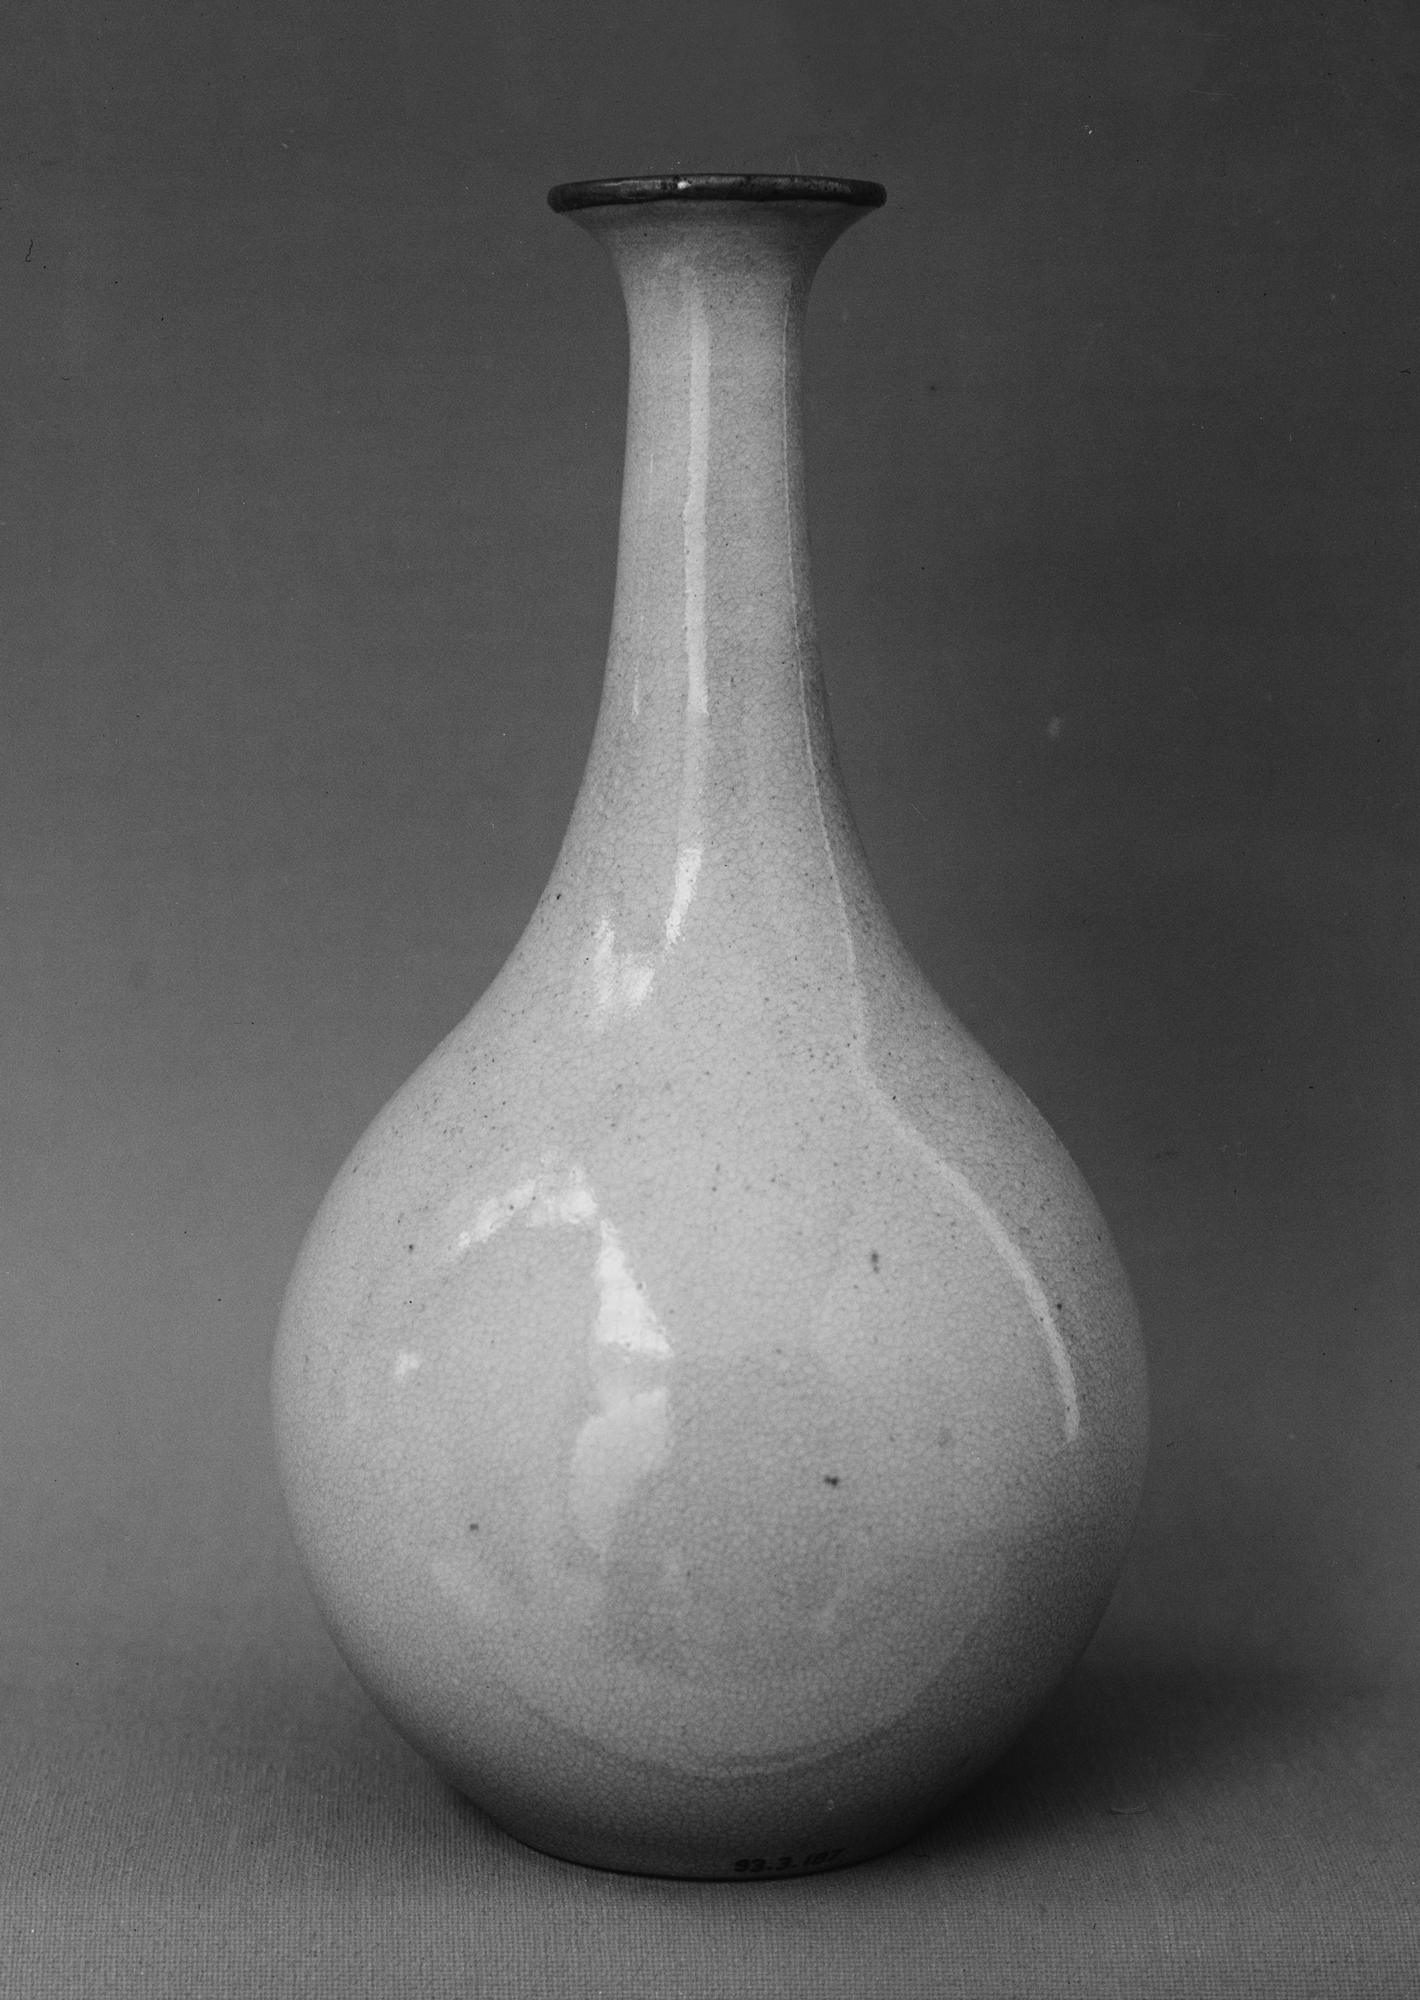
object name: bottle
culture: japanese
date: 1700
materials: clay, glaze